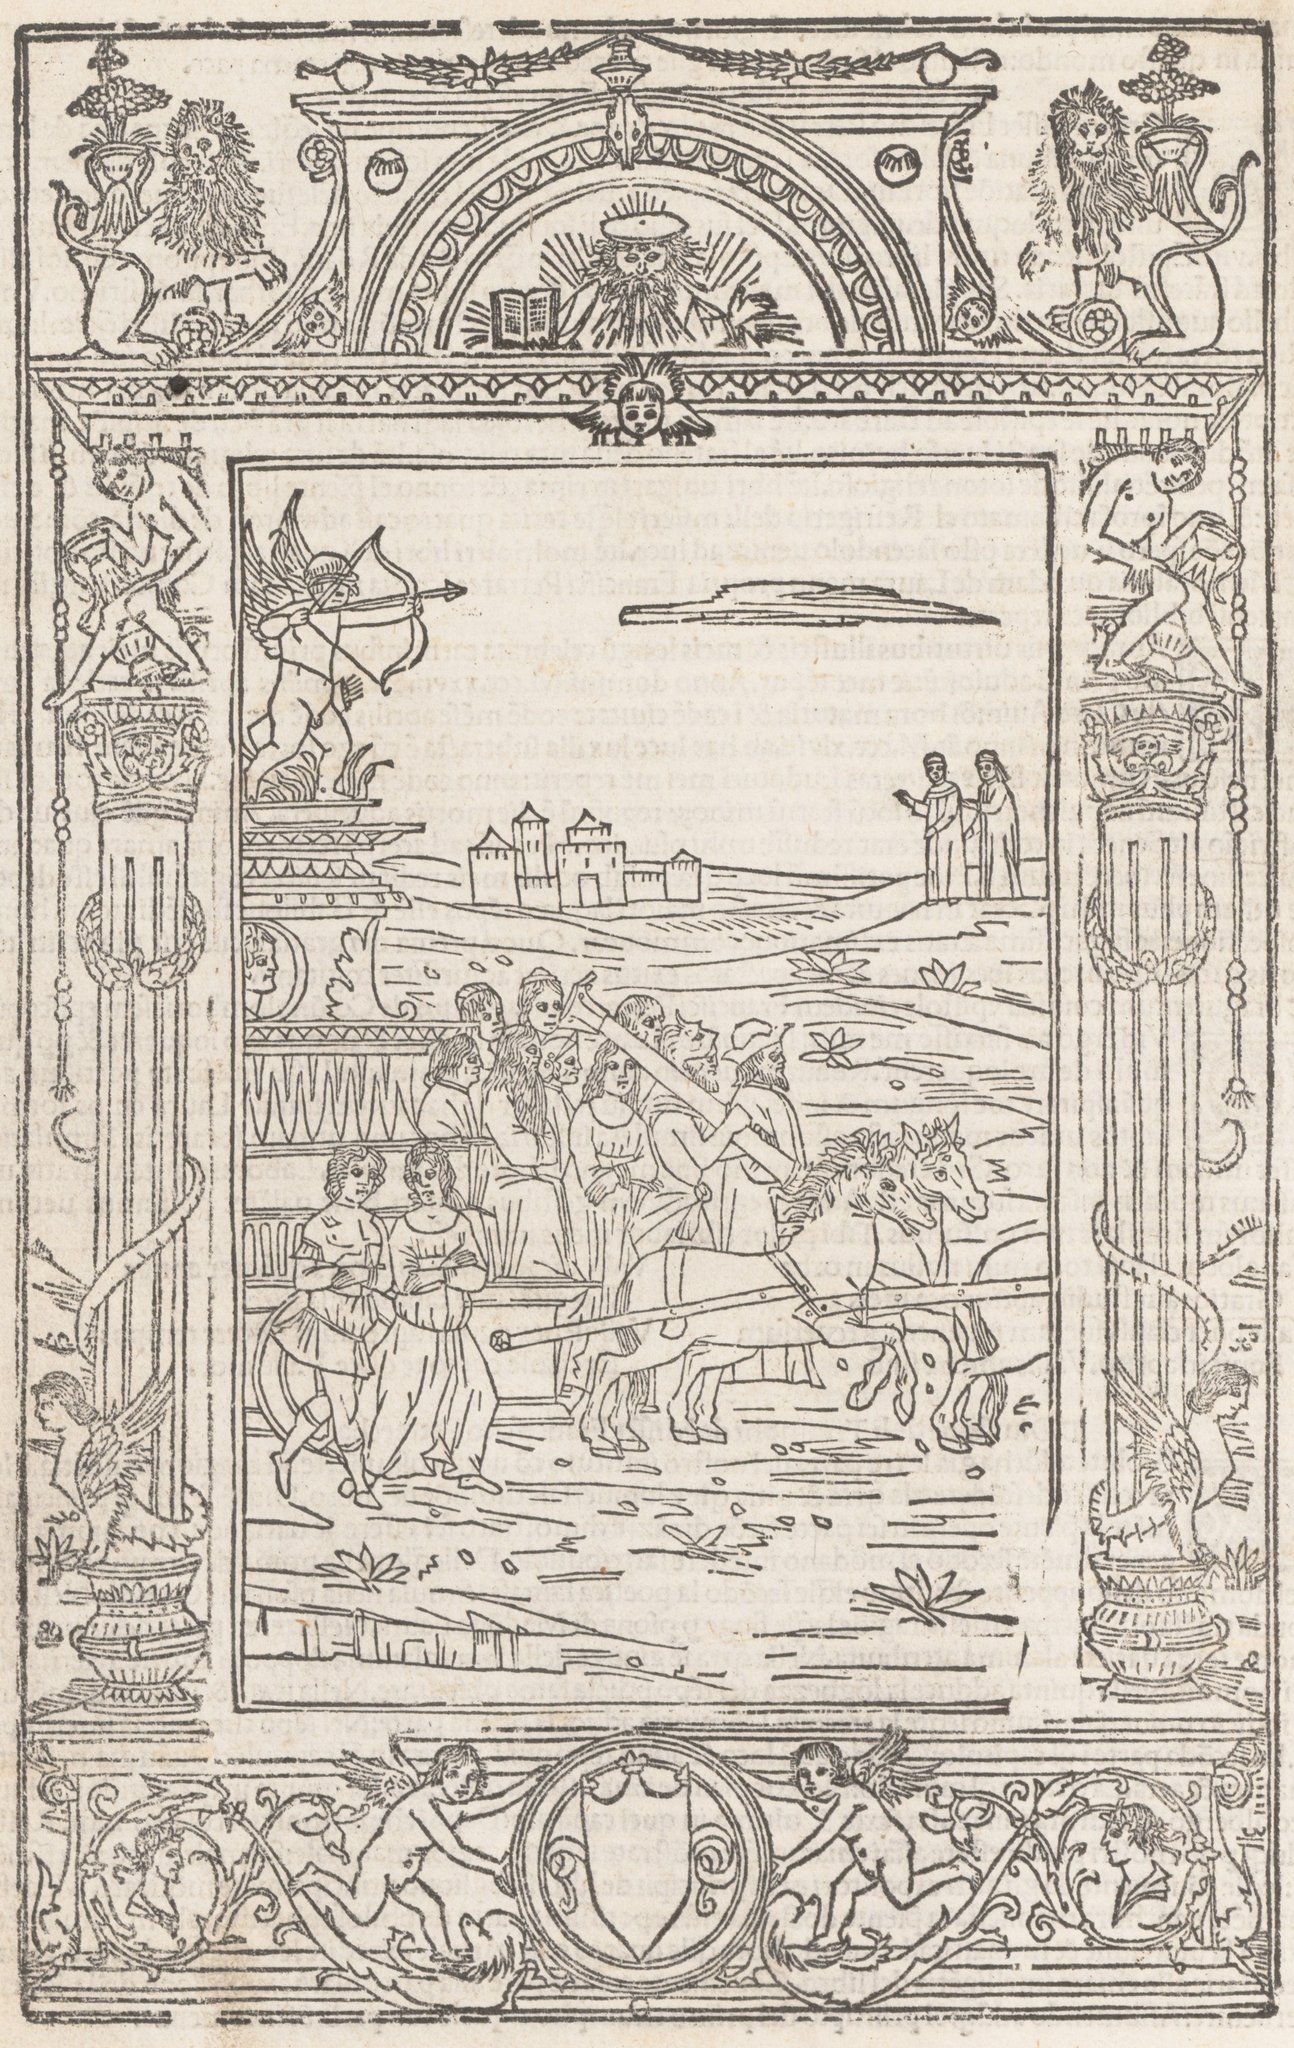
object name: book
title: Opera..Triumphi, Soneti, & Canzone..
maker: francesco petrarca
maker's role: author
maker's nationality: italian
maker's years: 1304-1374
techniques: printing, woodcut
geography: venice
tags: men,women,cupid,horses